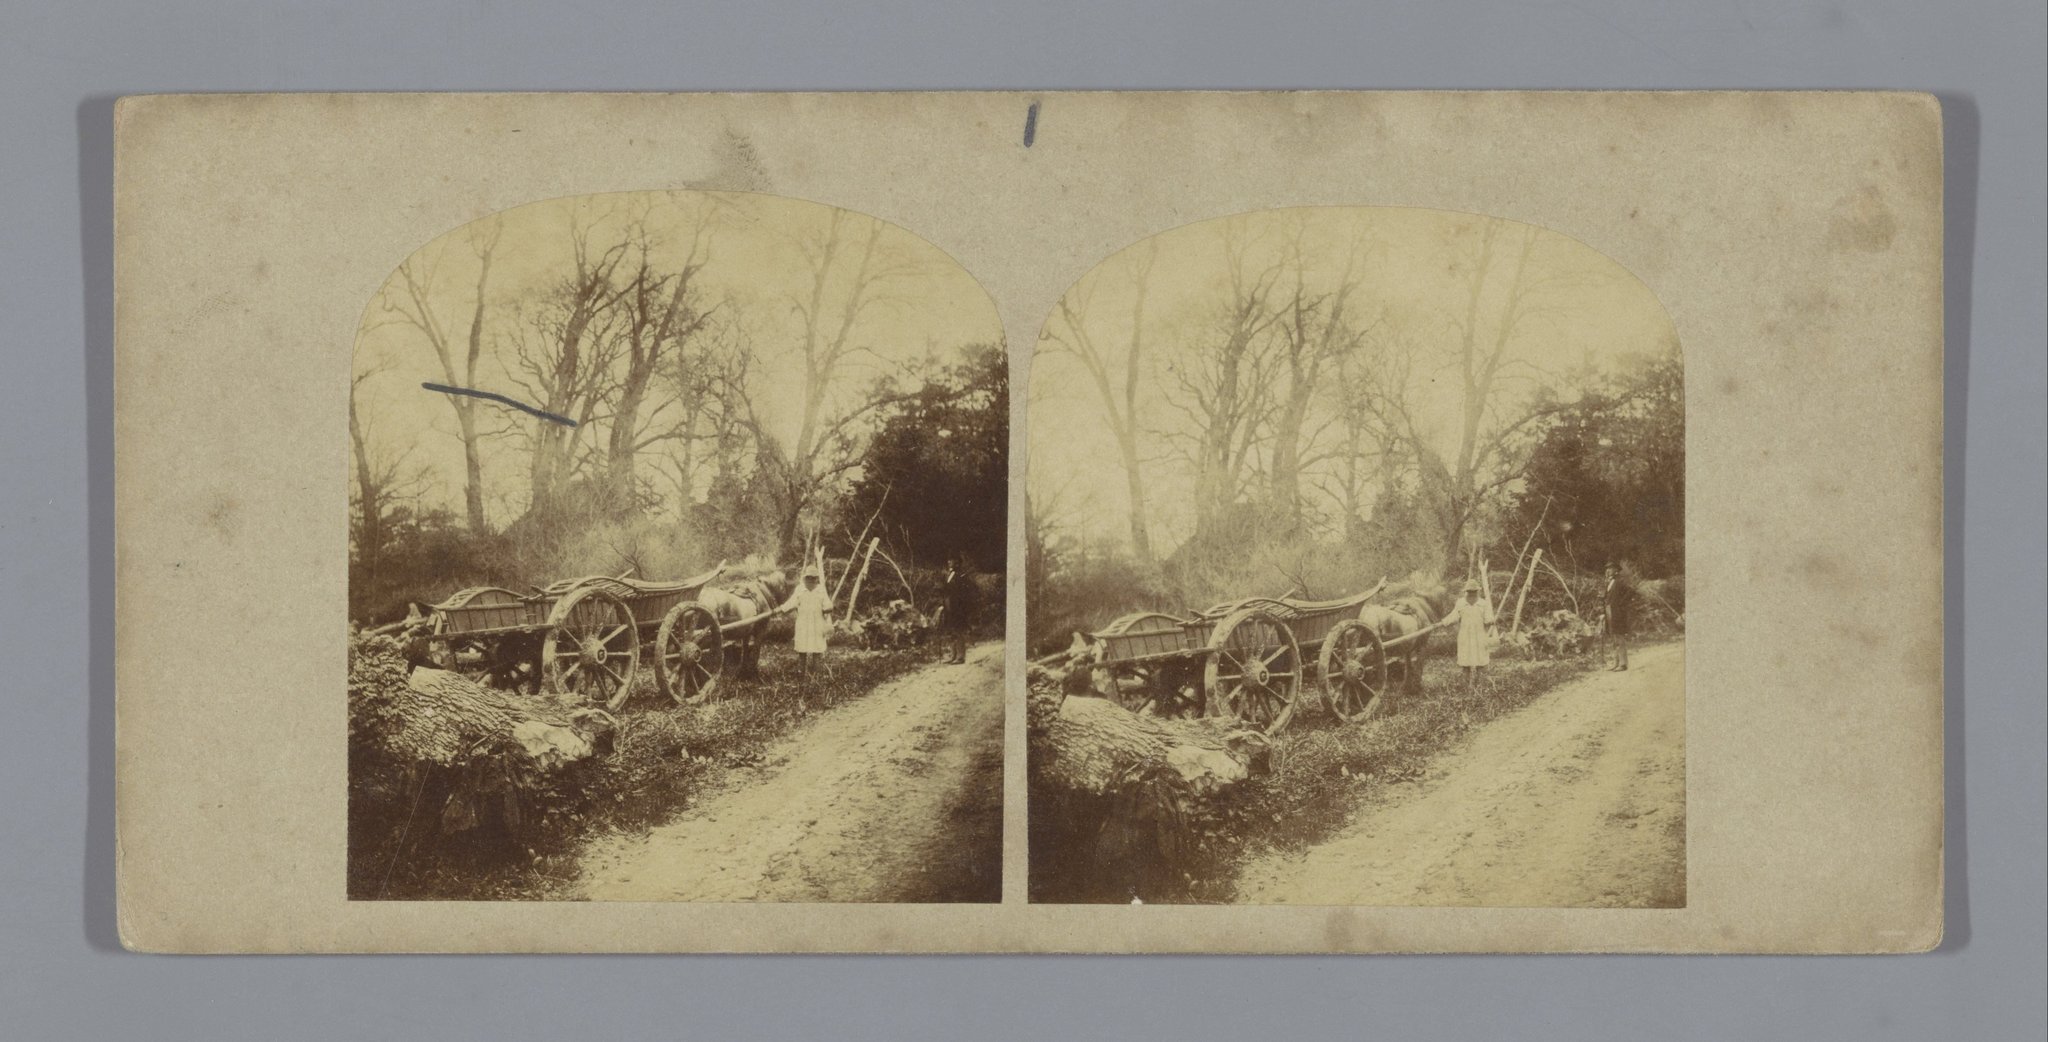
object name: stereograph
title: Scenes in our village. Lane leading to the farm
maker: Anonymous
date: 1850-1880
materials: cardboard, photographic support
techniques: albumen print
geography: england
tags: four-wheeled, animal-drawn vehicle, e.g.: cab, carriage, coach, village lane, alley, europe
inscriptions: number: ‘60’, inscription